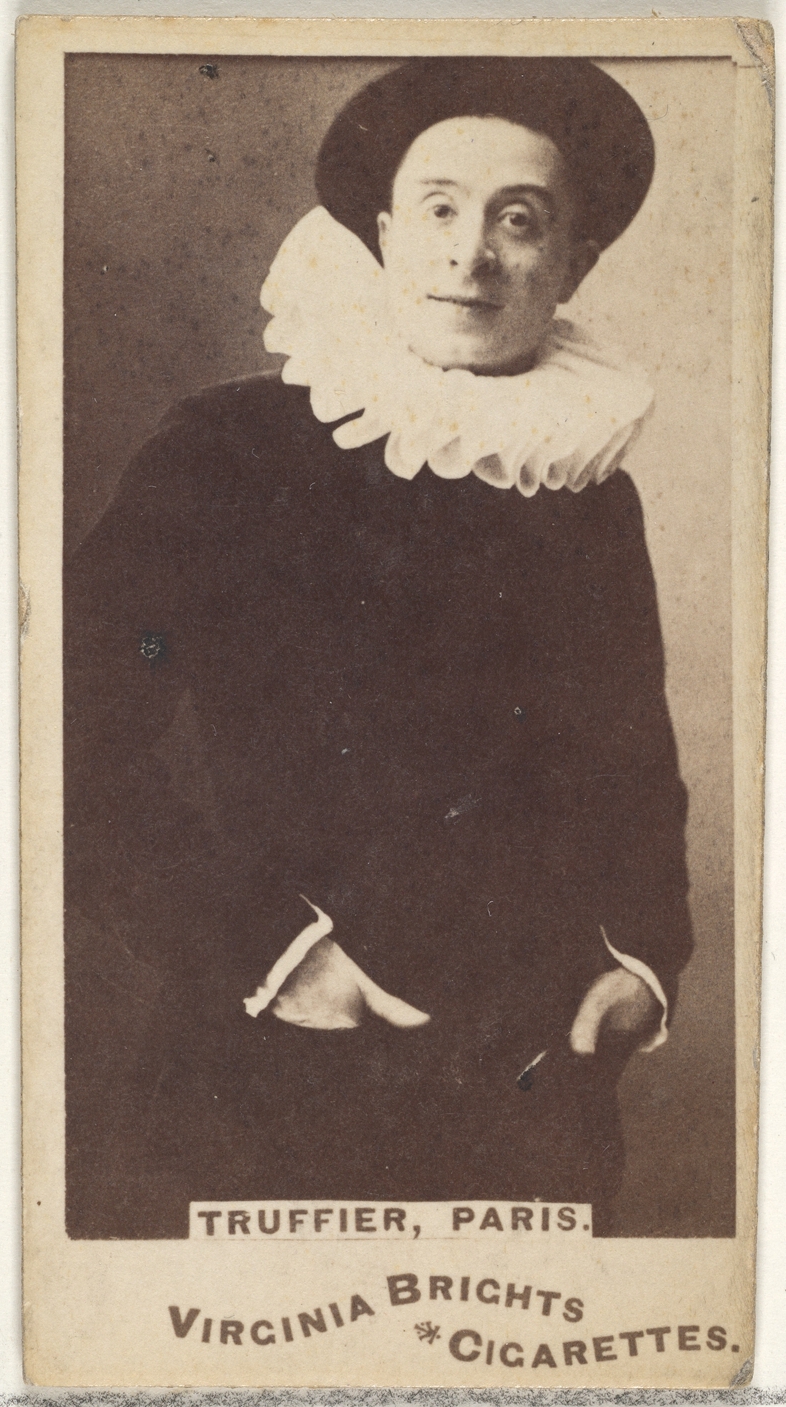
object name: photograph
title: Truffier, Paris, from the Actors and Actresses series (N45, Type 1) for Virginia Brights Cigarettes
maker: allen & ginter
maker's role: publisher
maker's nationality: american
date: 1888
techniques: albumen silver print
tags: men,portraits,actors